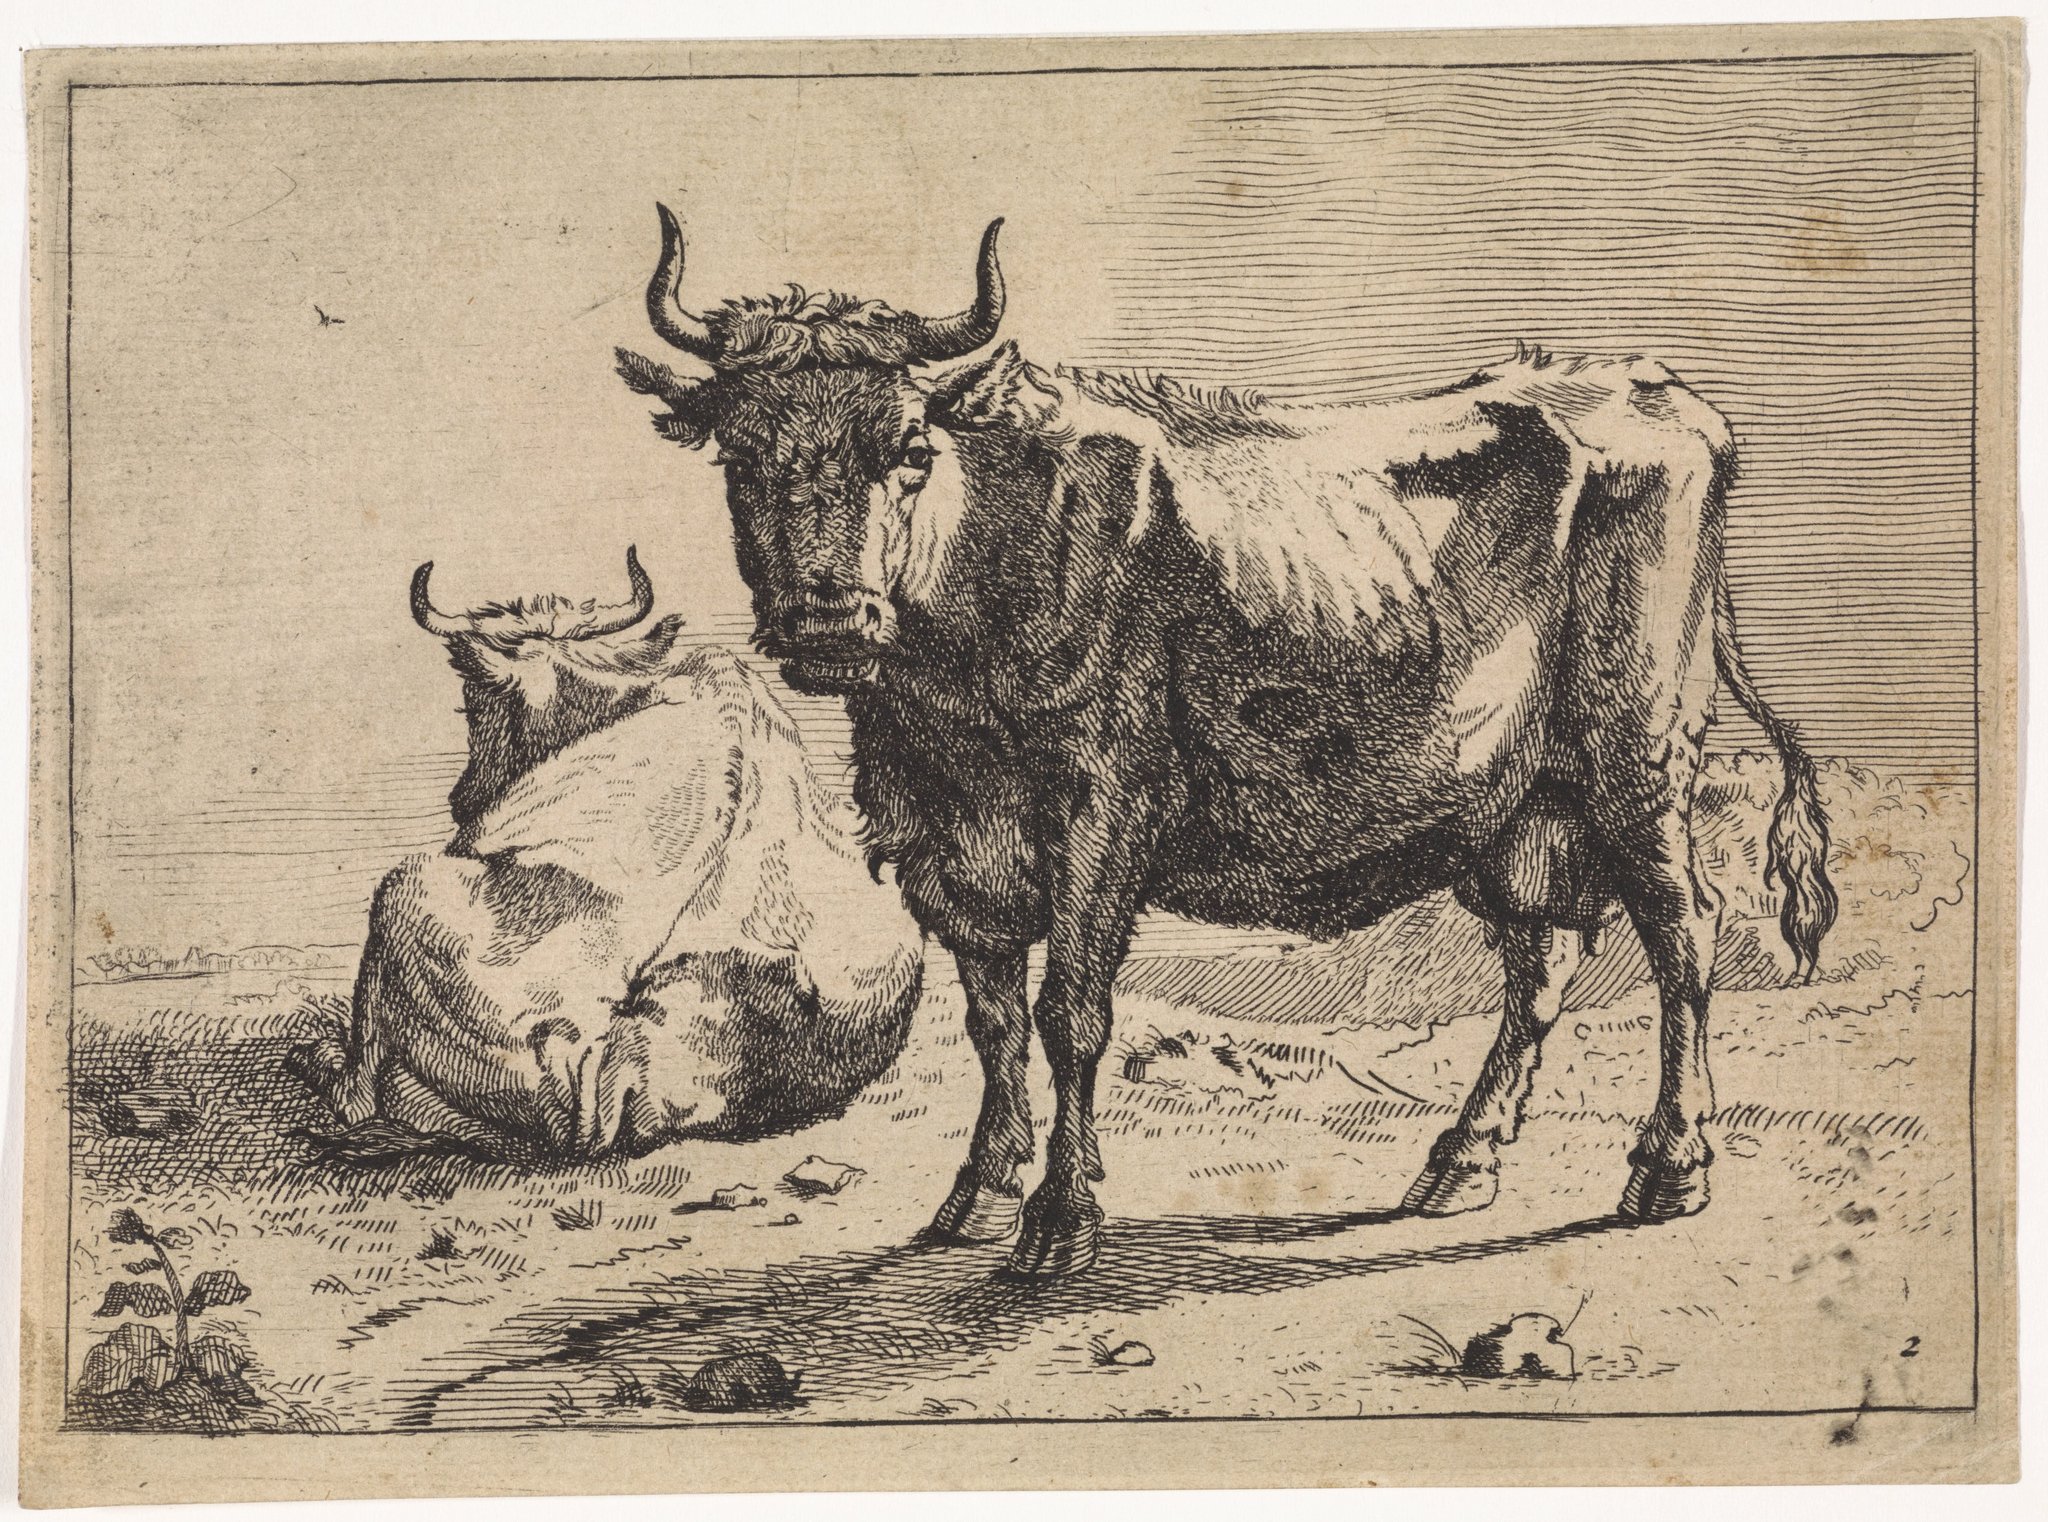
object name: print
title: Het Bullenboekje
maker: Anonymous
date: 1650-1700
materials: paper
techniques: etching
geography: netherlands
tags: cow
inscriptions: collector's mark: Lugt 2228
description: Deze prent is een kopie in spiegelbeeld naar de tweede staat van de tweede prent uit de serie Het Bullenboekje van Paulus Potter.